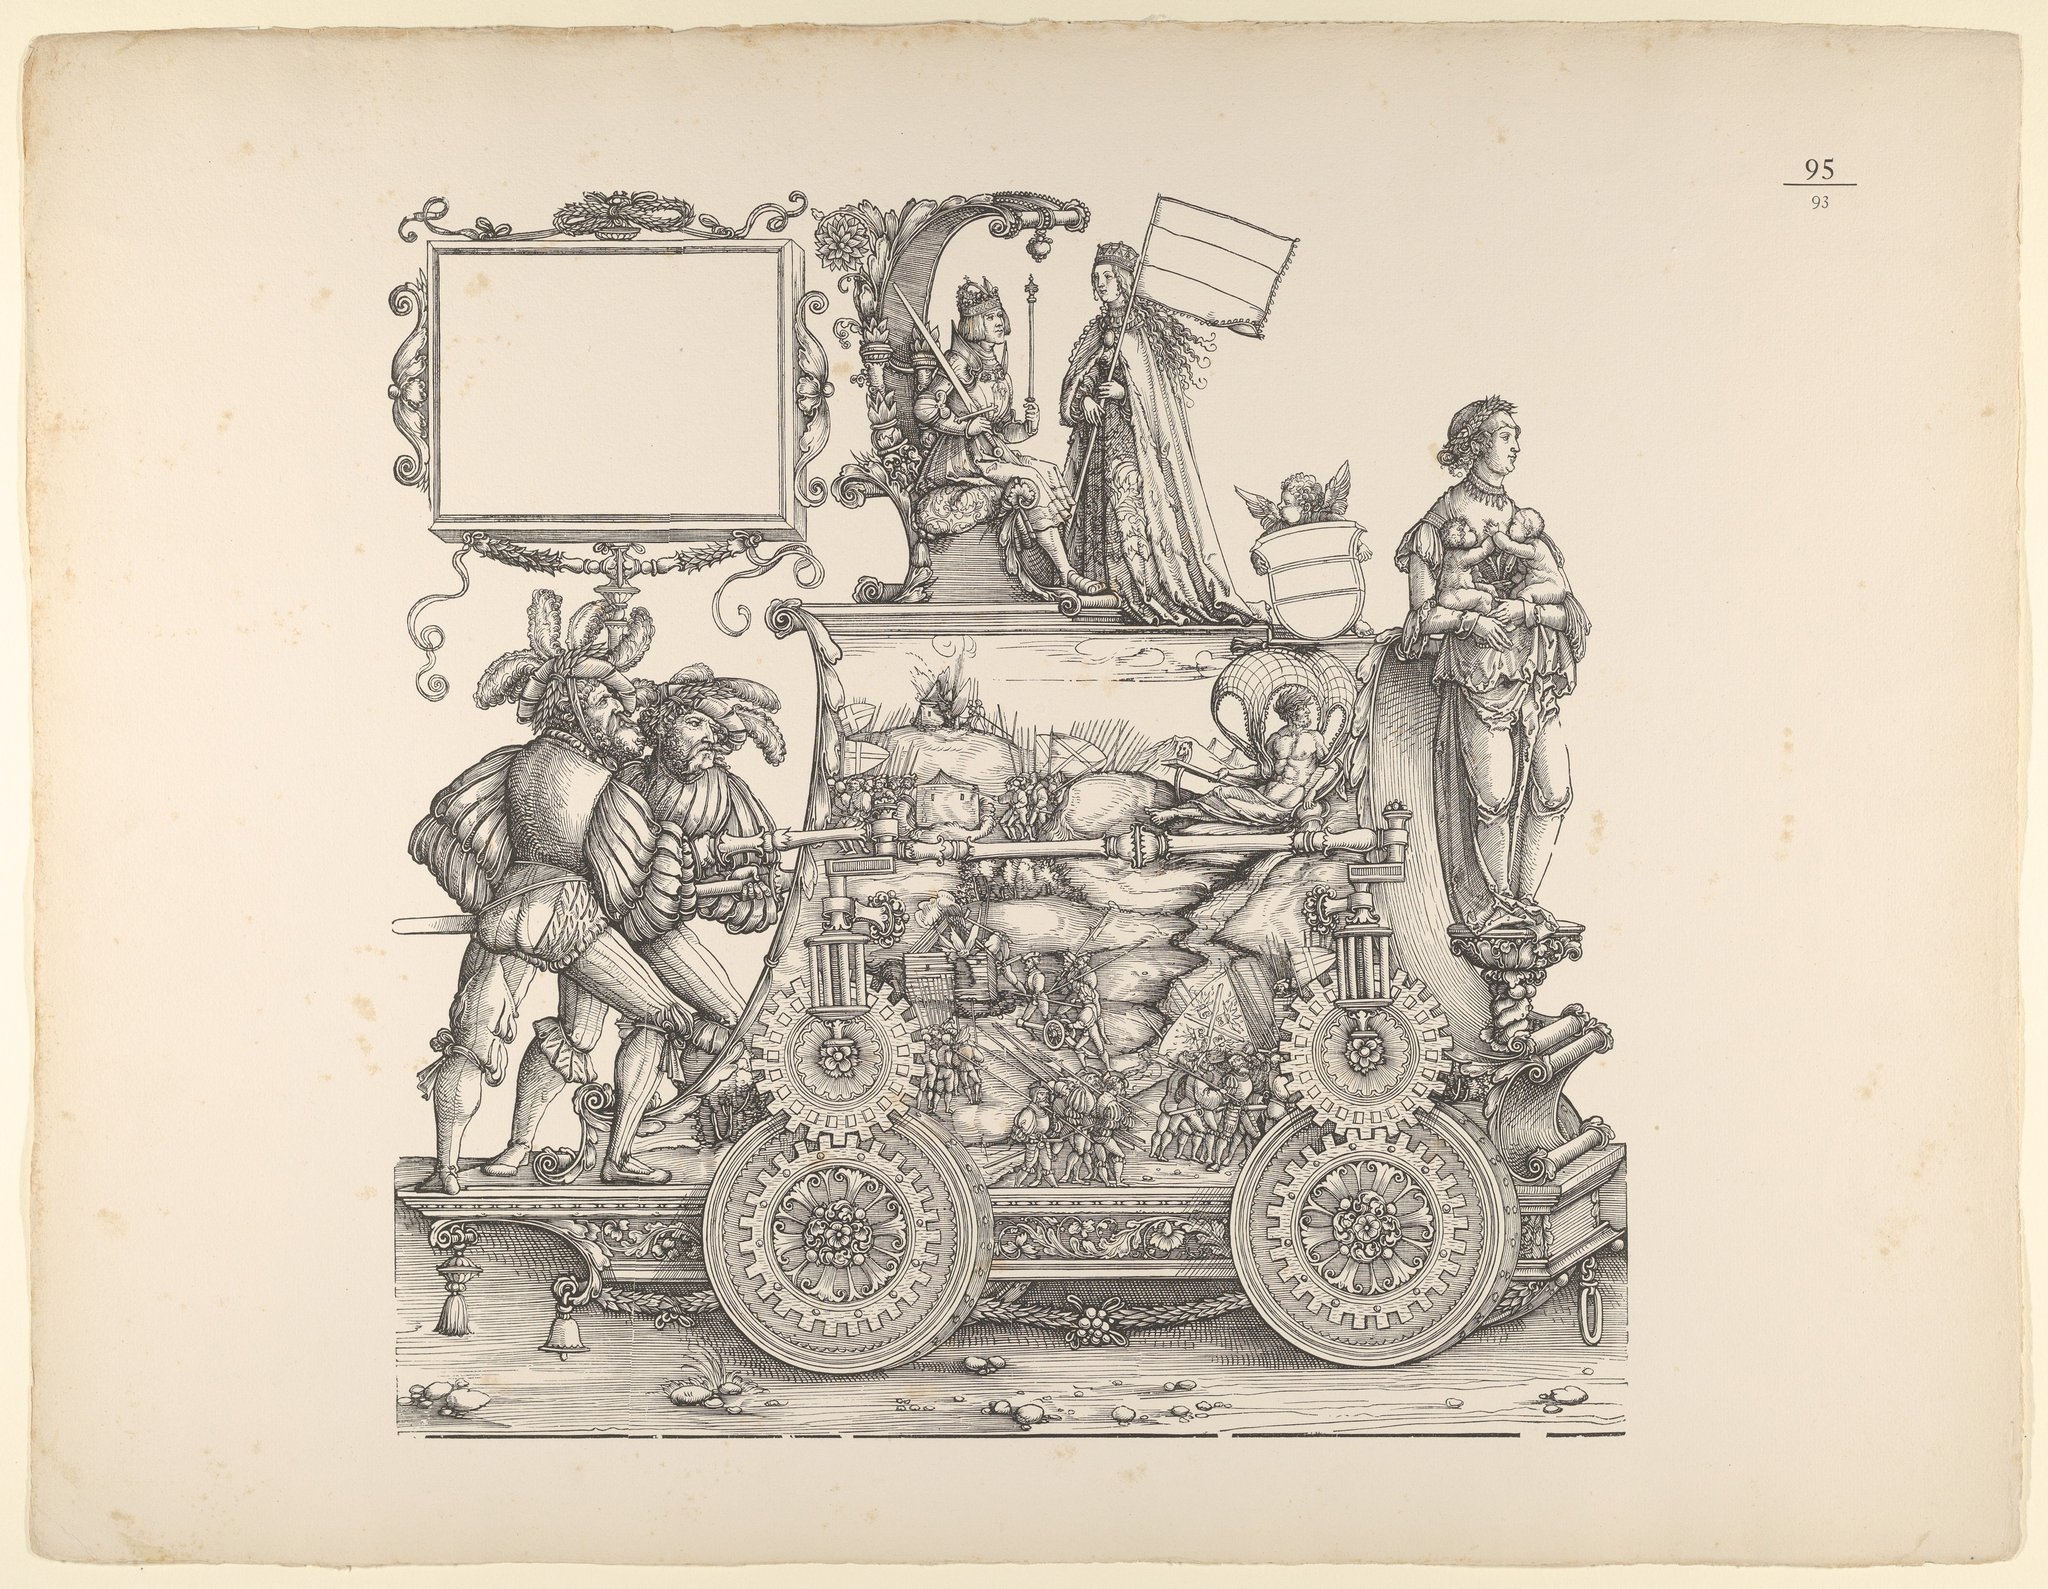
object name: print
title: Wartime Triumphs, from The Triumphal Procession of Emperor Maximilian (Triumph Des Kaisers Maximilian I)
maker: hans burgkmair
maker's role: artist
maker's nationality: german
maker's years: 1473-1531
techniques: woodcut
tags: infants,men,women